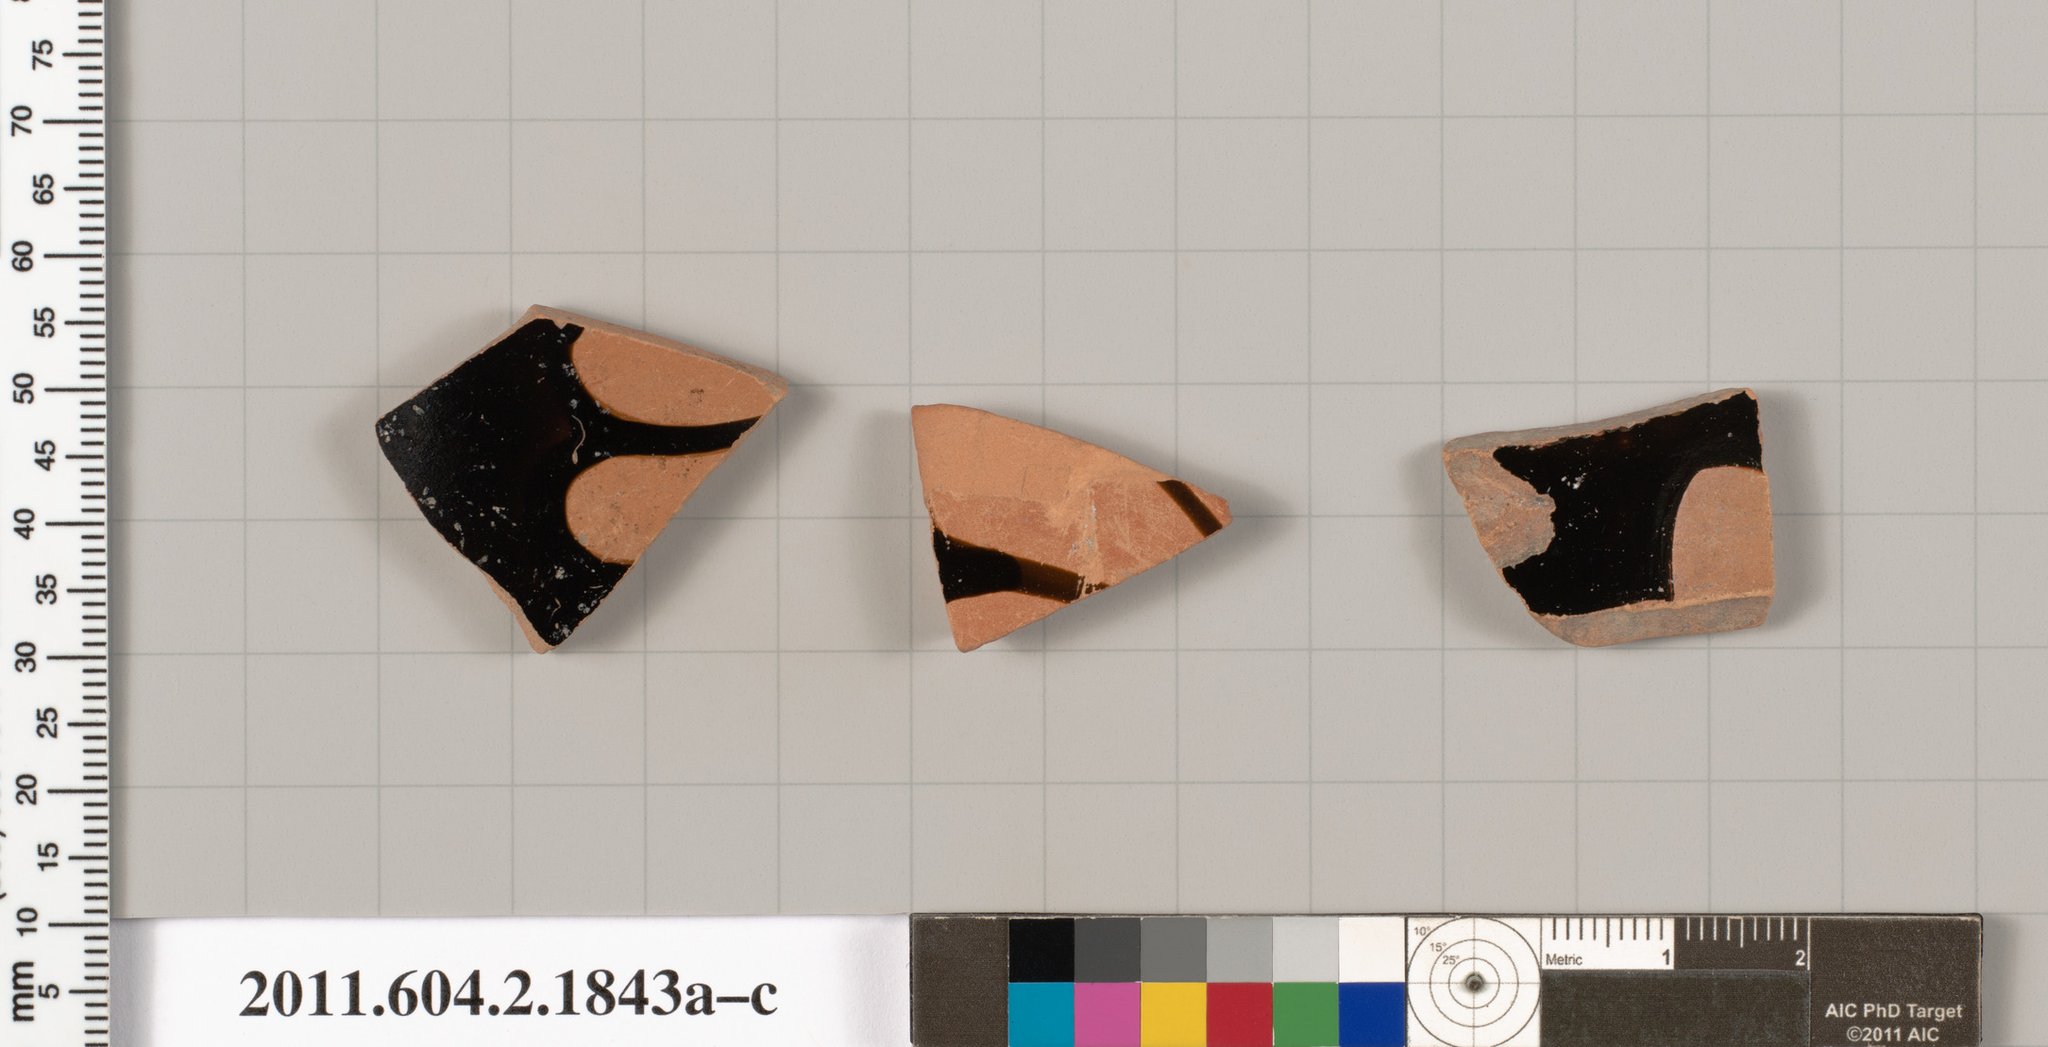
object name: skyphos fragment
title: Terracotta fragments of skyphoi (deep drinking cups)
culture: greek, attic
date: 450-426 BCE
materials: terracotta